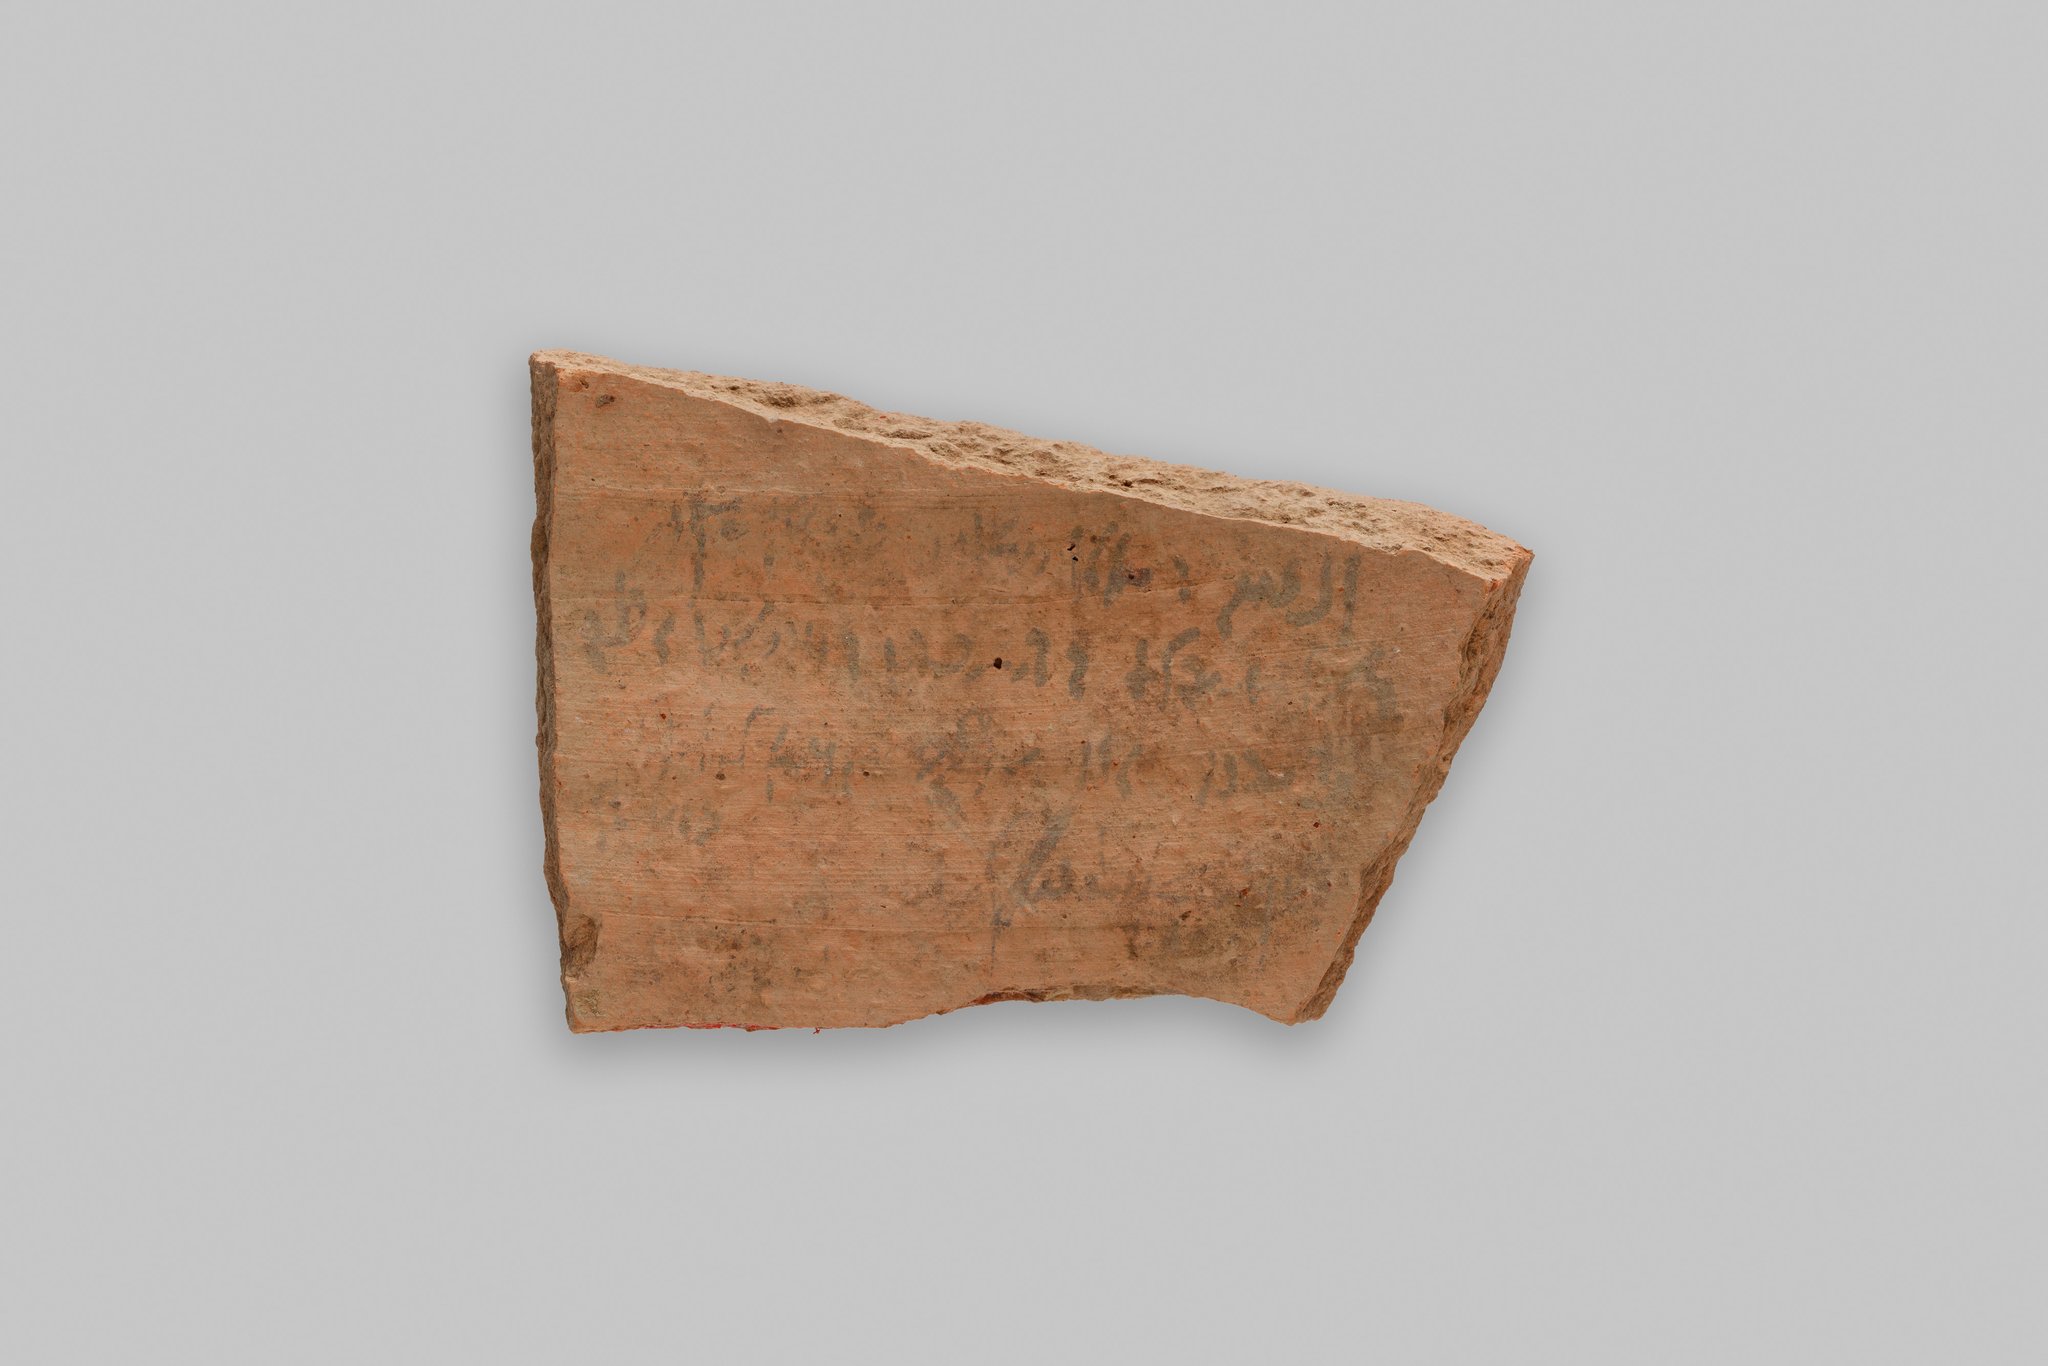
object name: ostracon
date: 400-30 BCE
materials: ink, pottery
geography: egypt